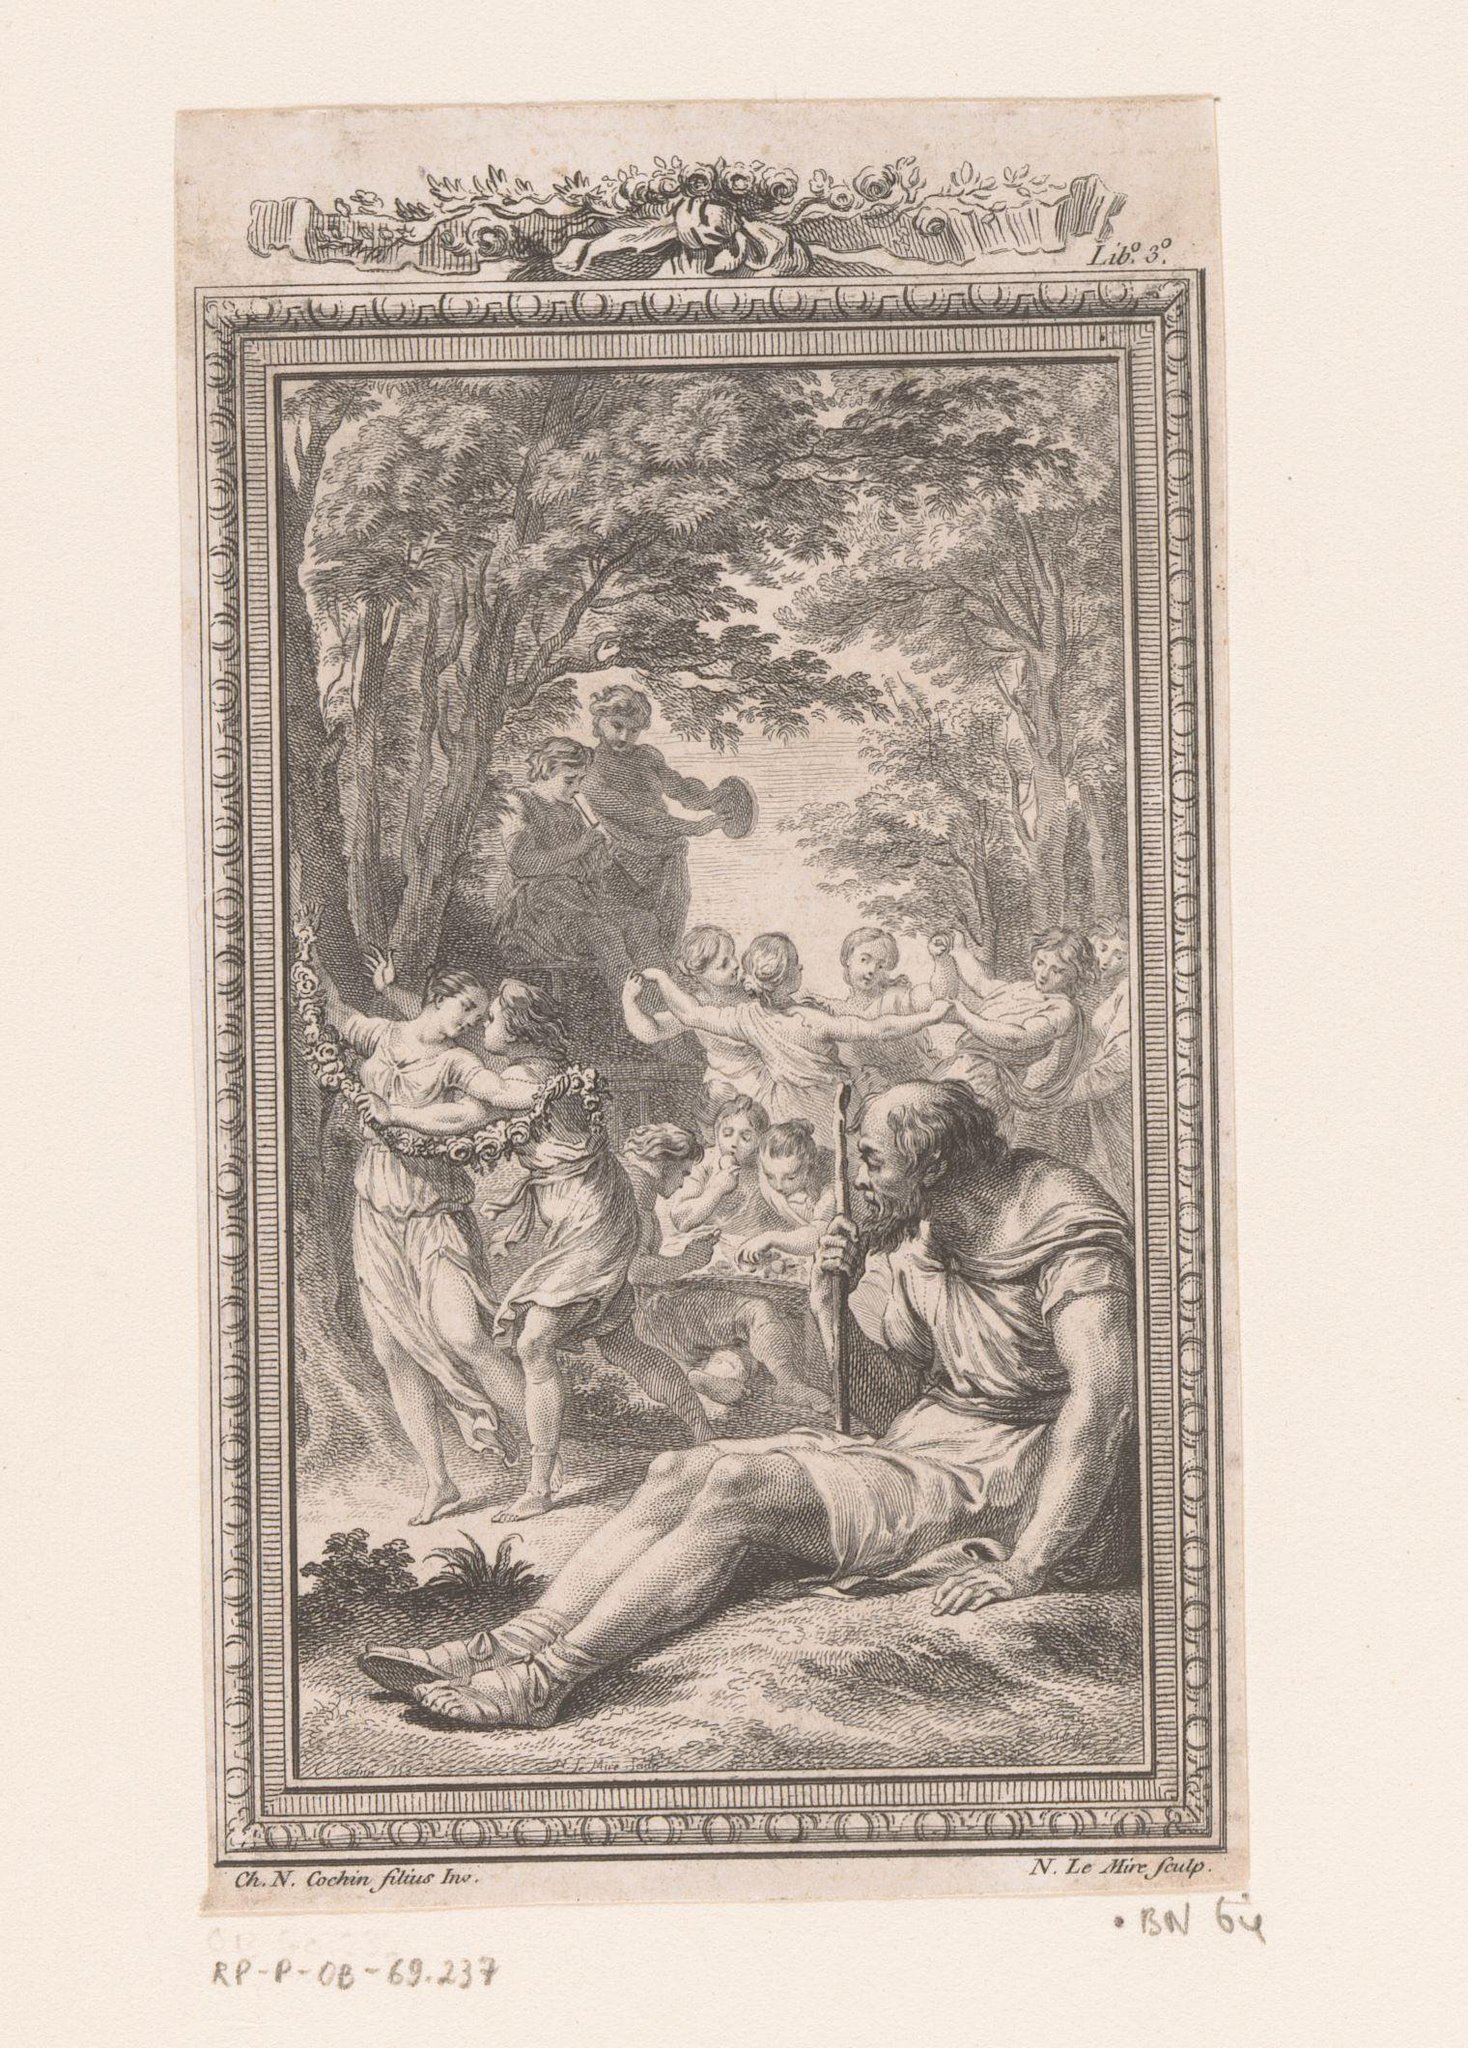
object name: print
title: Zittende man met stok en dansende vrouwen in een bos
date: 1753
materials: paper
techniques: engraving, etching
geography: amsterdam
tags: group dancing, sitting on the ground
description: Prent uit: Carus, Lucretius Titus en Marchetti, Alessandro. Di Tito Lucrezio Caro Della natura delle cose libri sei. Amsterdam: s.n. 1754, dl. 2.